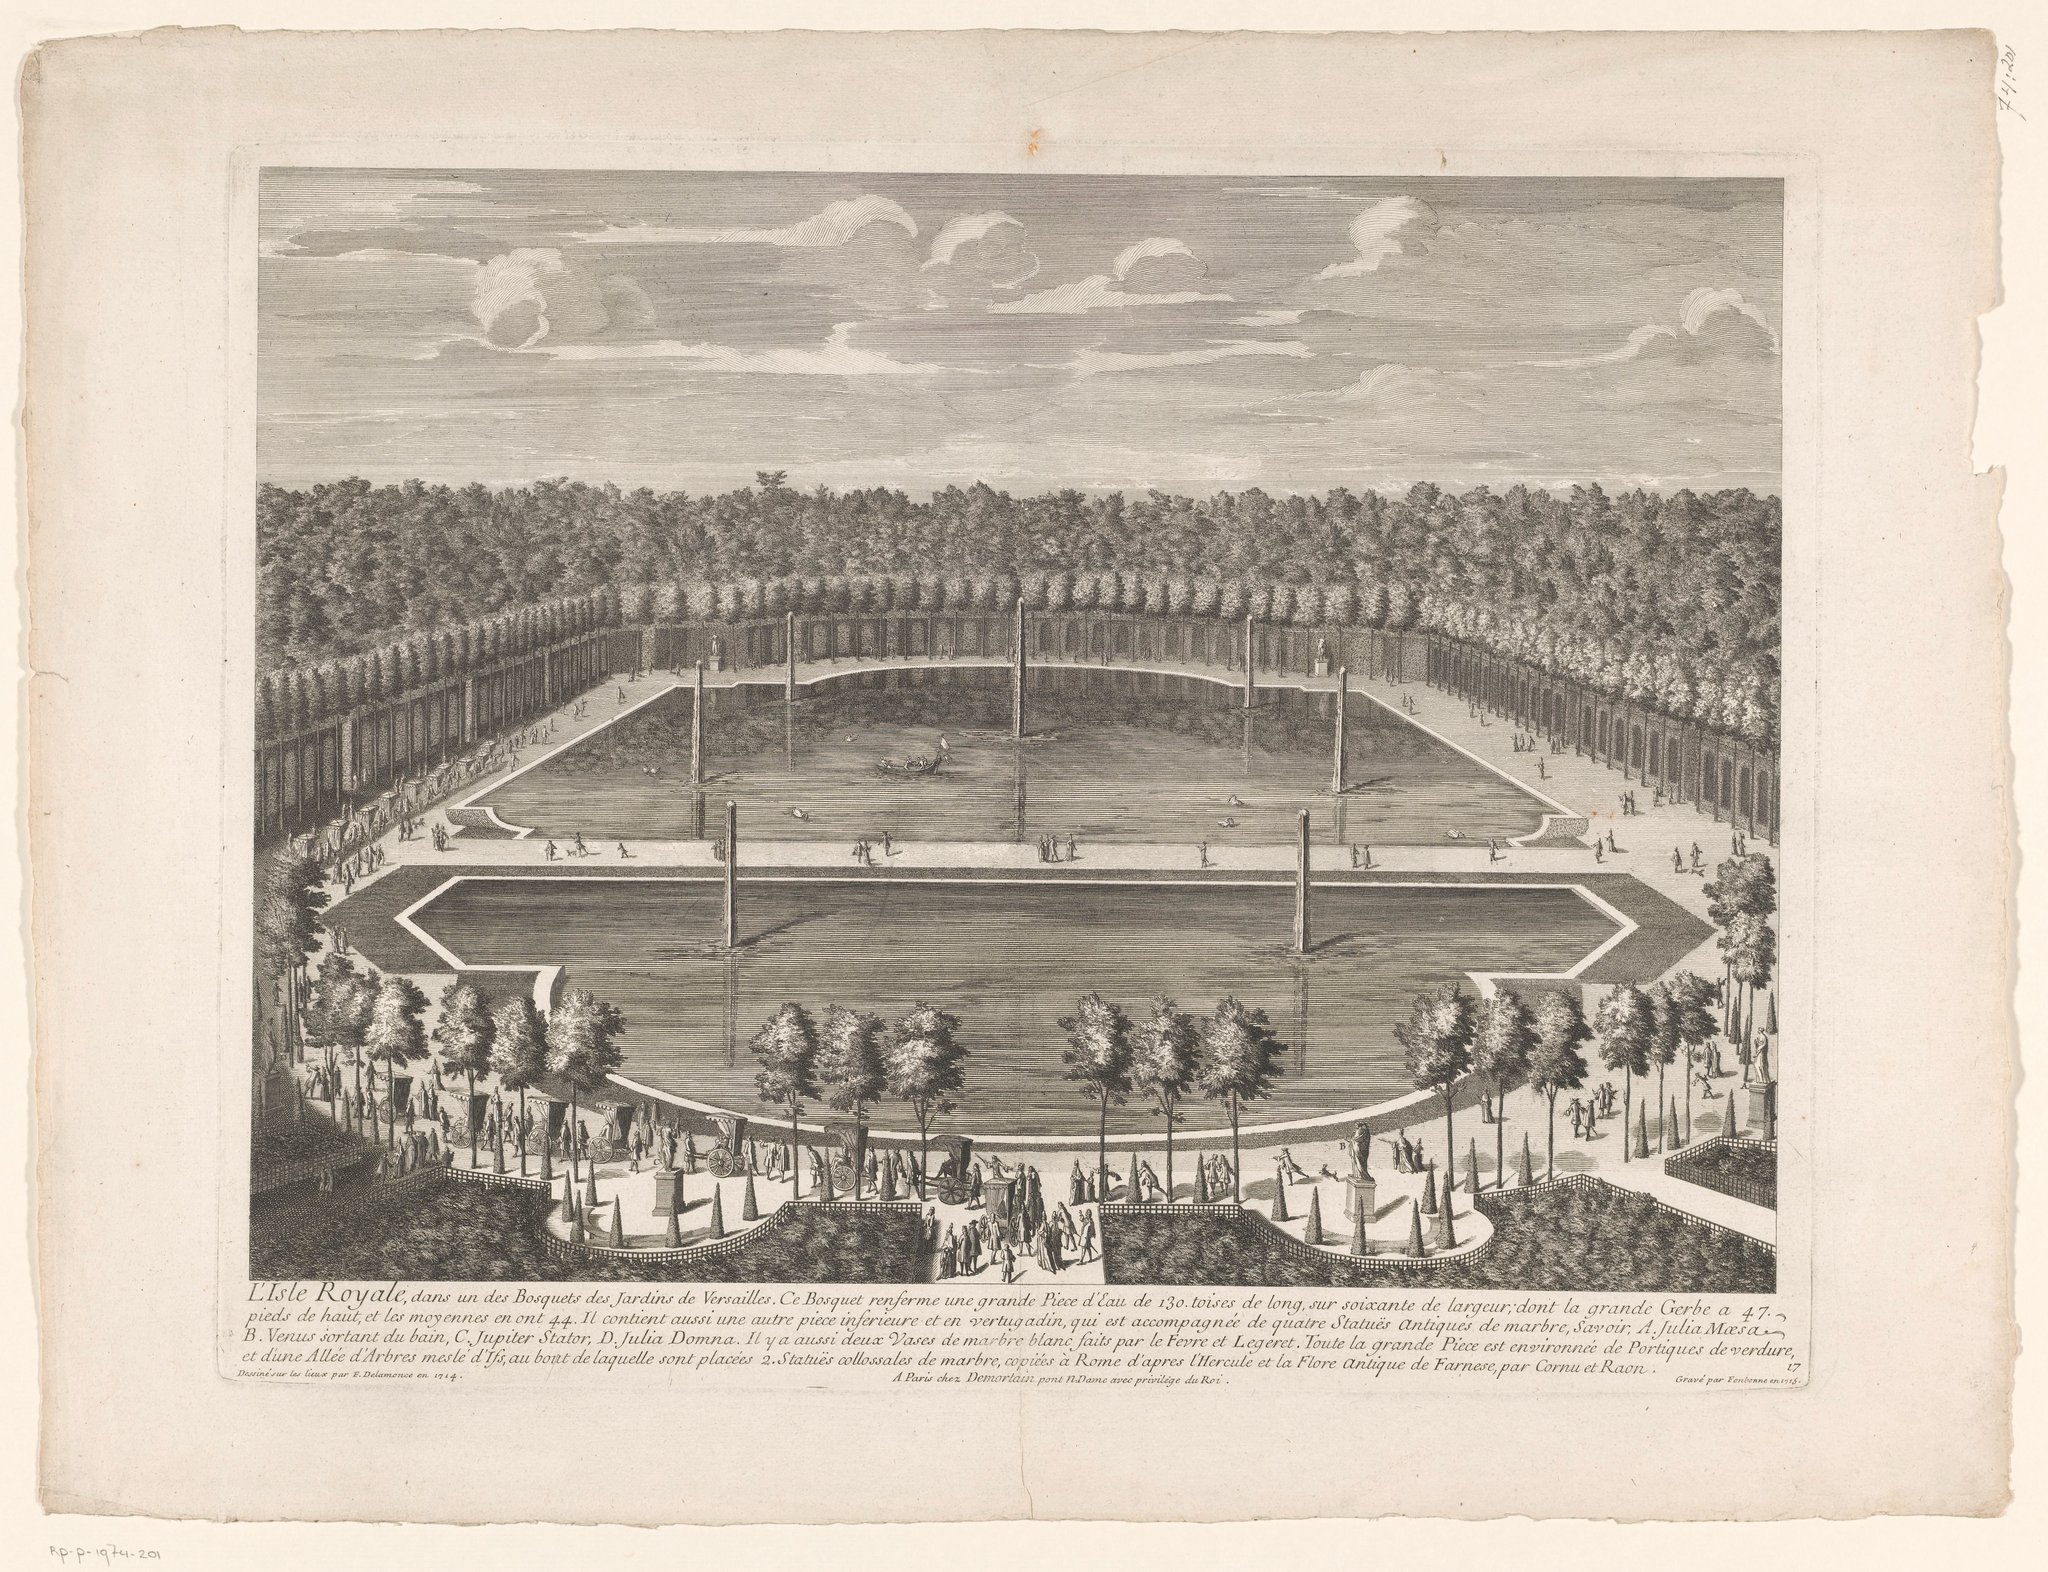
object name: print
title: L'Isle Royale, dans un des bosquets des jardins de Versailles (...)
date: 1715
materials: paper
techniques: engraving, etching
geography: paris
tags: french or architectonic garden; formal garden, garden pond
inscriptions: collector's mark: Lugt 2228, collector's mark: Lugt 2760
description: Prent ook gebruikt in: Les Plans, Profils, Et Elevations, Des Ville, Et Château De Versailles (...). Parijs: Gilles de Demortain, [1715].